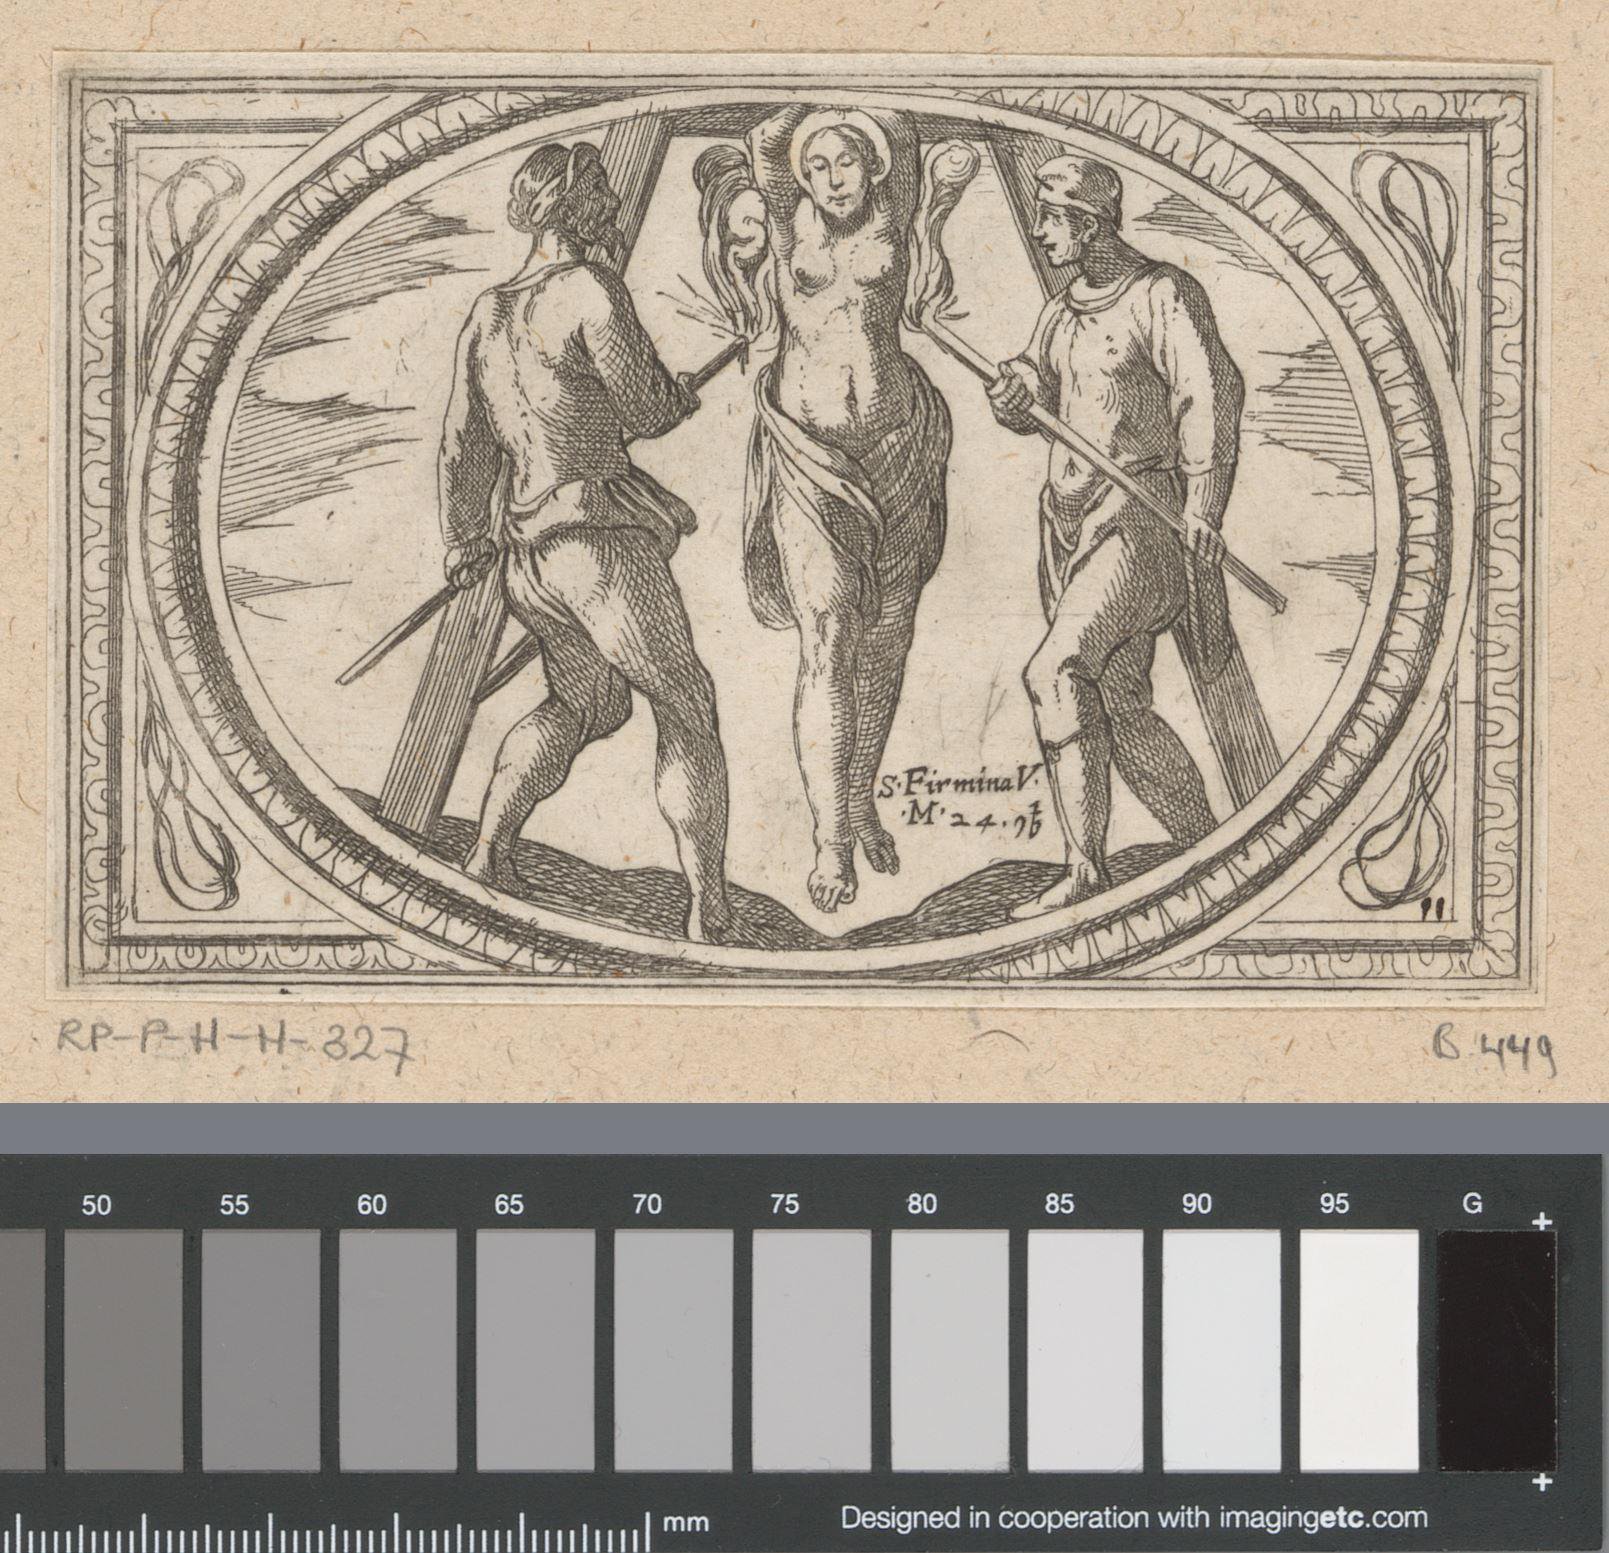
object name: print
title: H. Firmina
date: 1565-1630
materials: paper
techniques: etching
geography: rome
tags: martyr(s) (often with palm-branches) - qq - female martyr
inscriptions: number: ‘11’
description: Deze prent maakt deel uit van een reeks van 73 prenten (+ titelprent) met voorstellingen van Romeinse martelaressen.